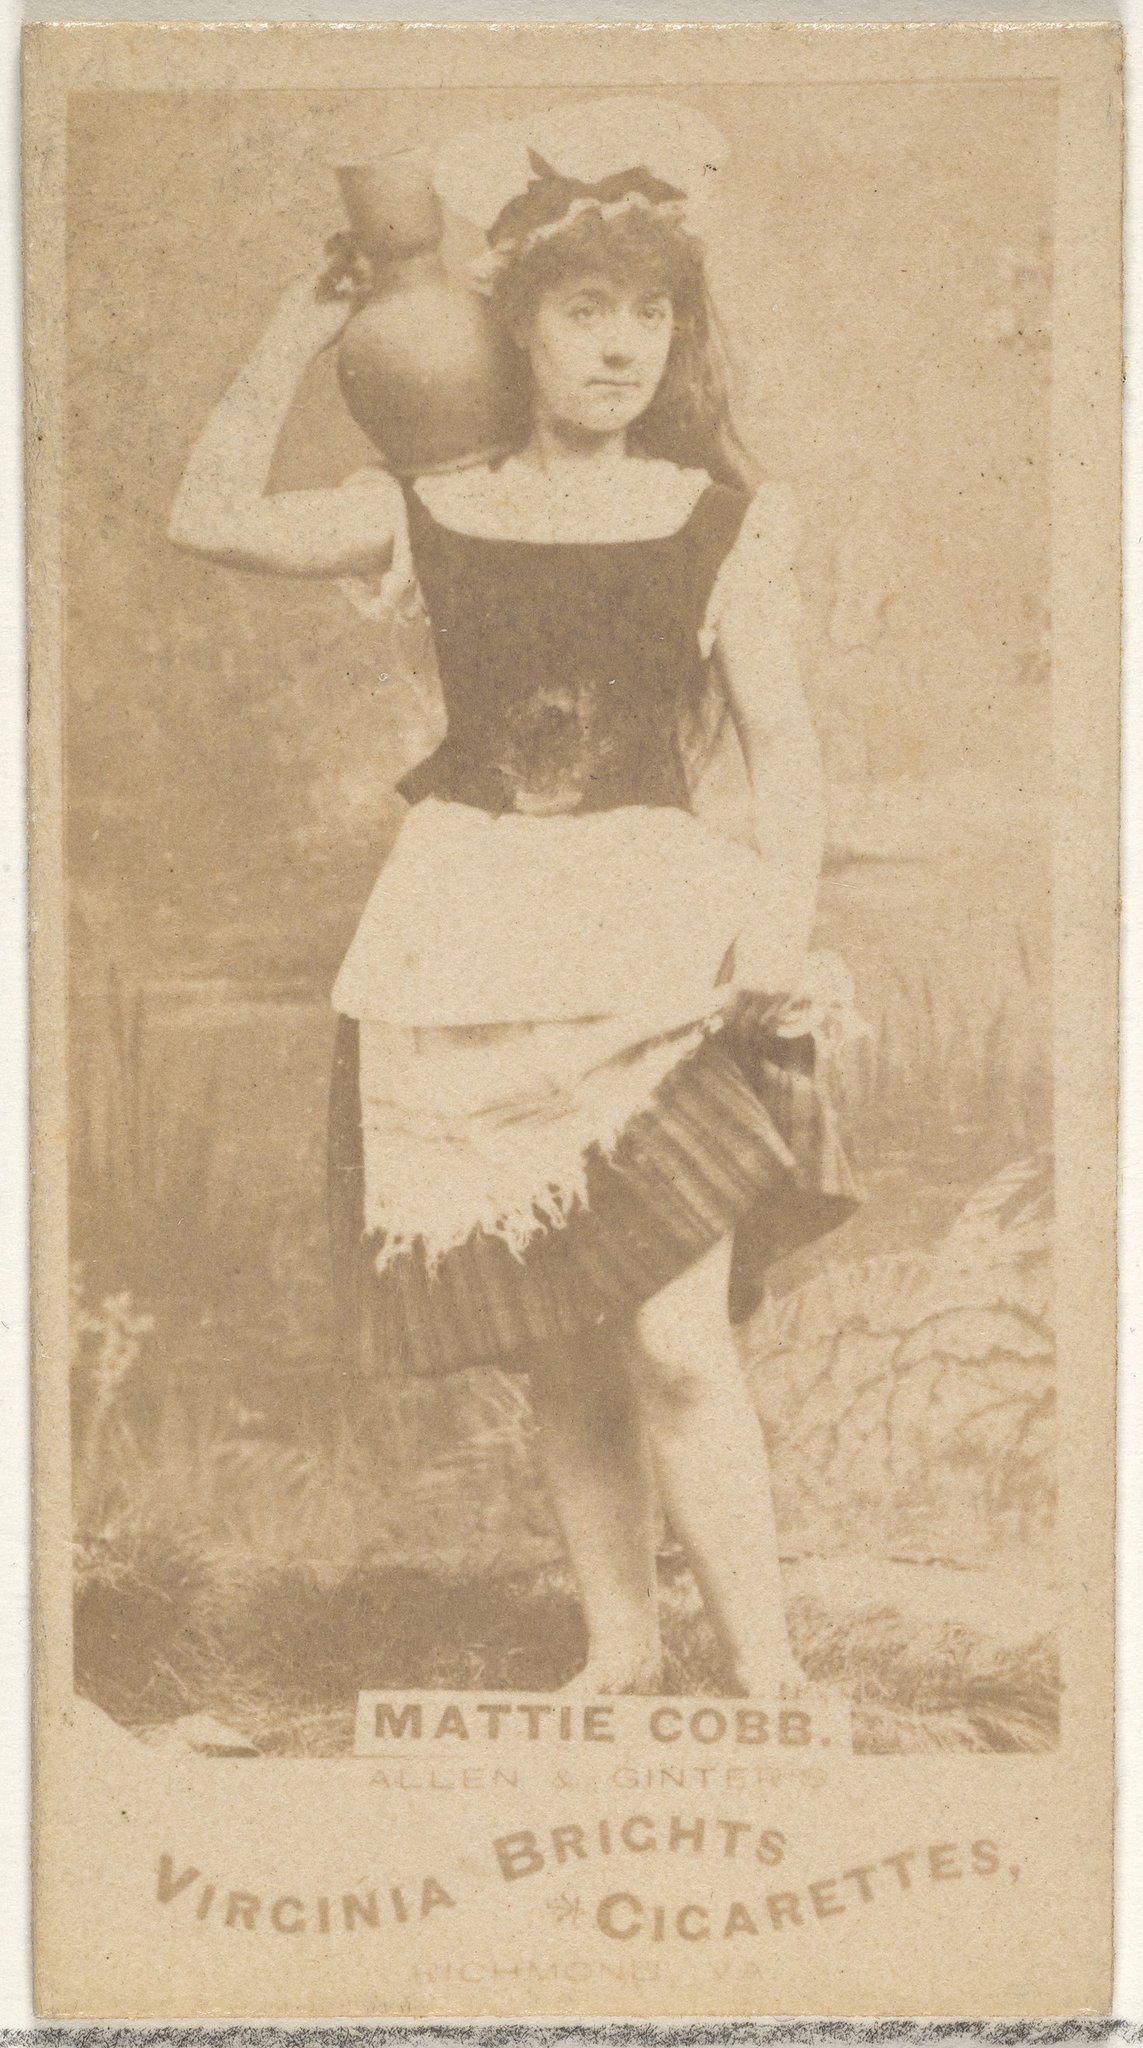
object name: photograph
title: Mattie Cobb, from the Actors and Actresses series (N45, Type 1) for Virginia Brights Cigarettes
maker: allen & ginter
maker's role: publisher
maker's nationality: american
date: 1888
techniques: albumen silver print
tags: portraits,women,actresses